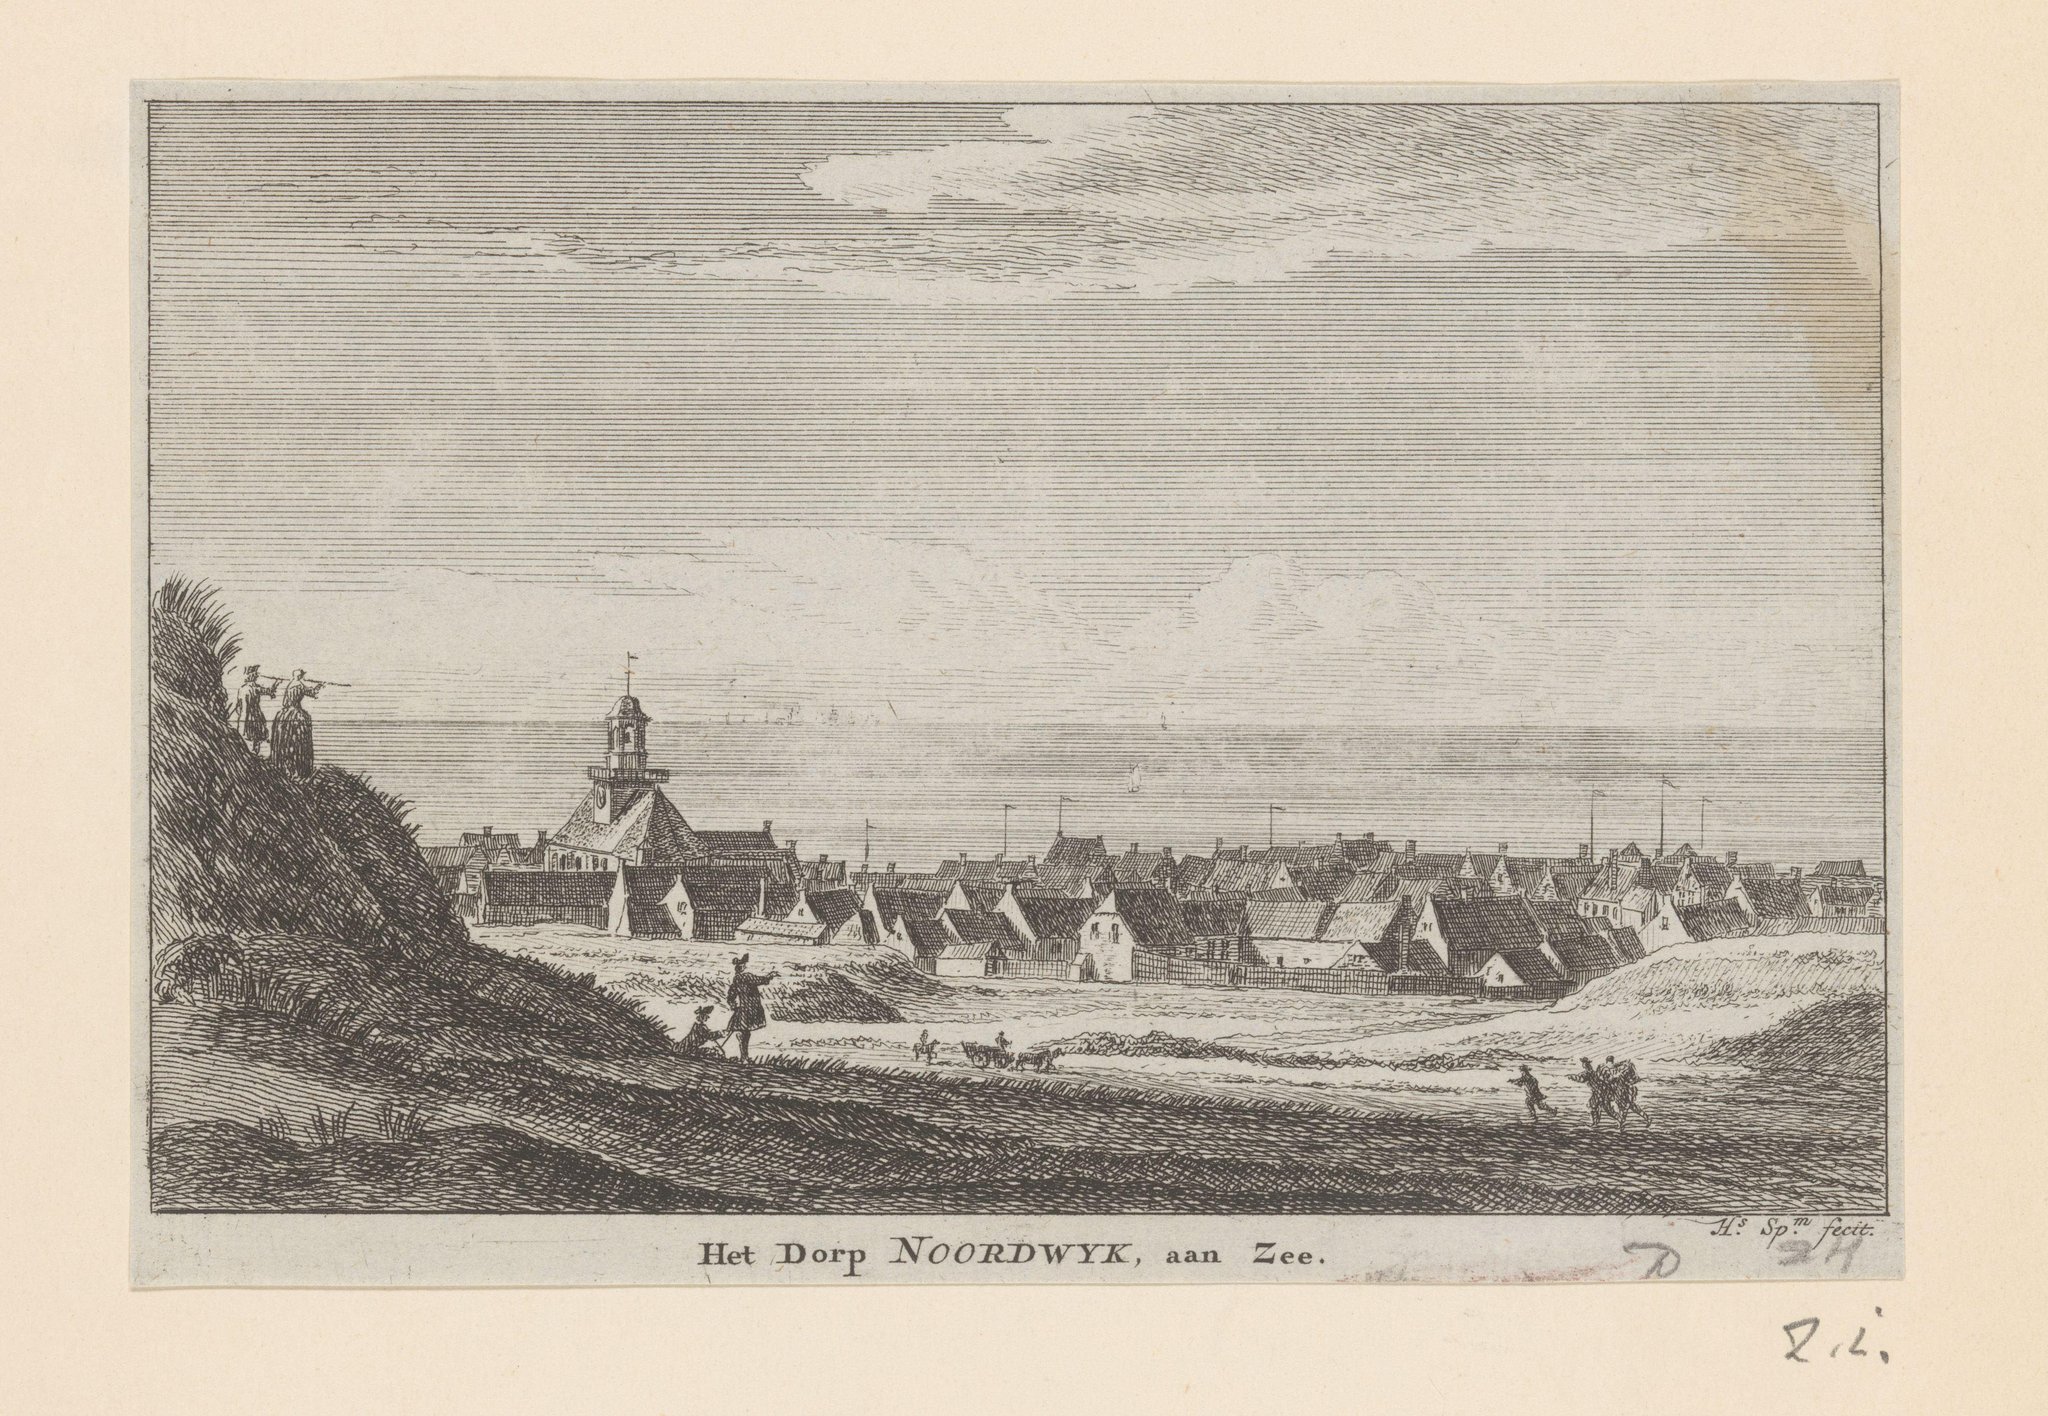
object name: print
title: Het dorp Noordwyk, aan zee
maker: hendrik spilman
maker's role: draughtsman, painter, print maker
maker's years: 1721-1784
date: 1742-1784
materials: paper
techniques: engraving, etching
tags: prospect of village, silhouette of village, dune coast, church (exterior)